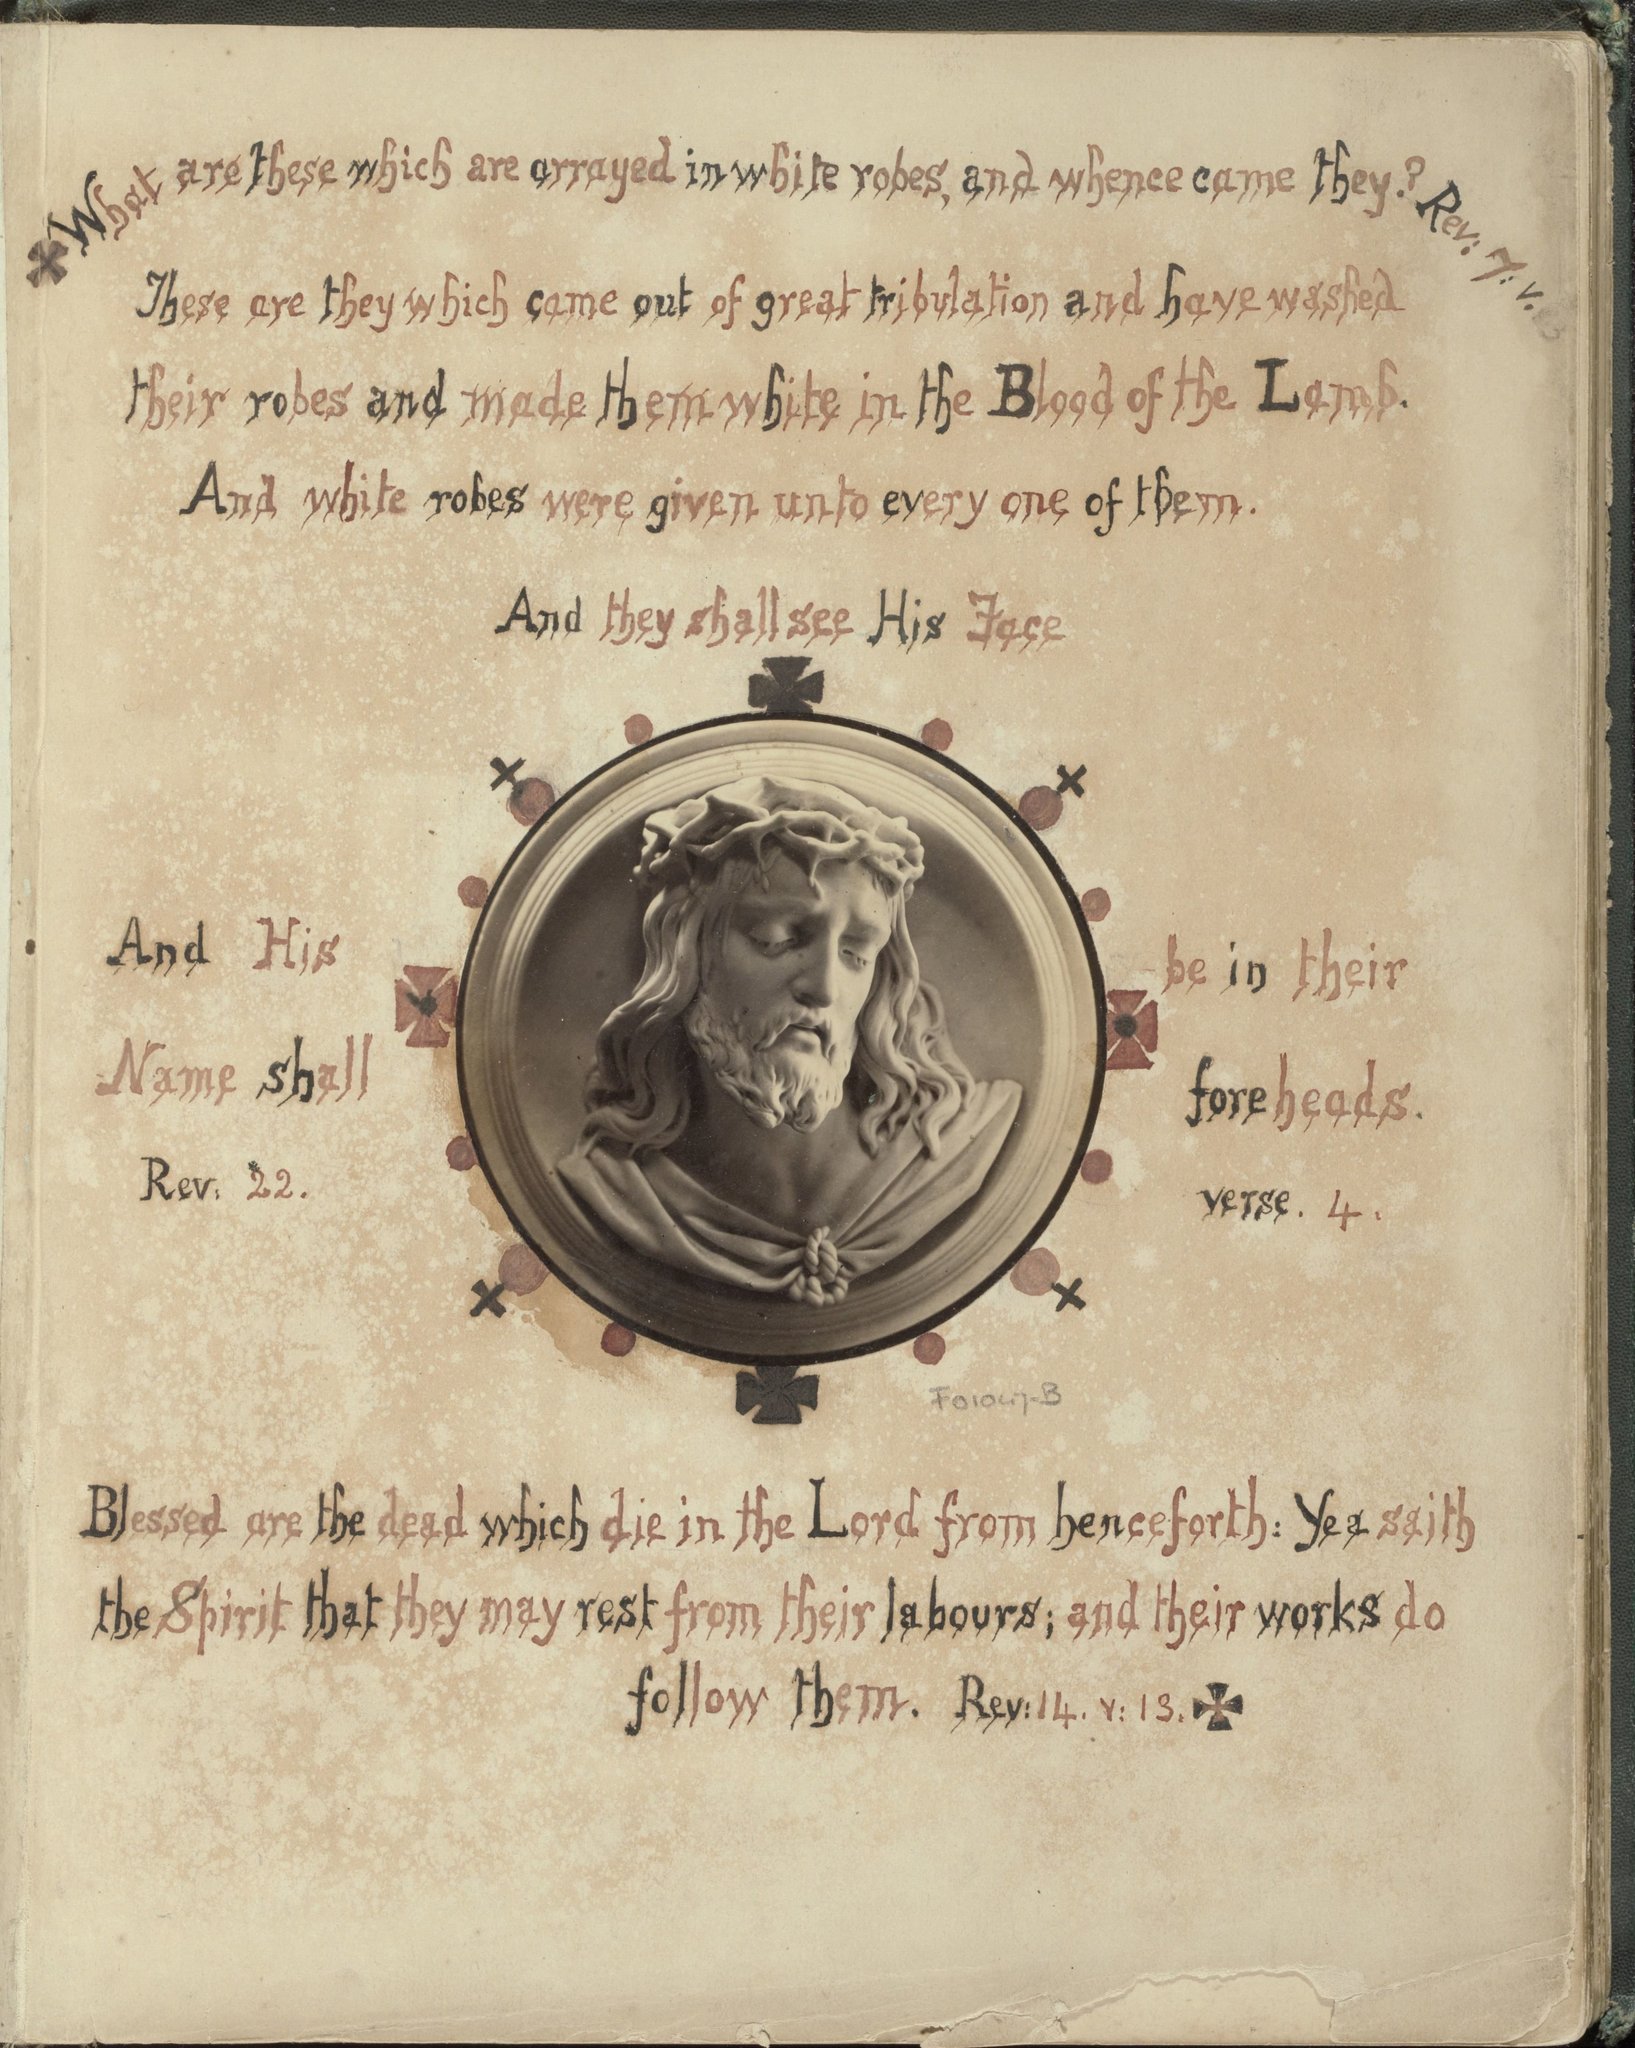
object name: album leaf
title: Tondo met Christuskop met doornenkroon, omgeven door Engelse tekst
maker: Anonymous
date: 1871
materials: cardboard, paper, photographic support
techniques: albumen print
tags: christ suffering (with crown of thorns, head usually turned sidewards)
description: Onderdeel van Herdenkingsalbum van rooms-katholieke geestelijken gevallen tijdens de Commune van Parijs.